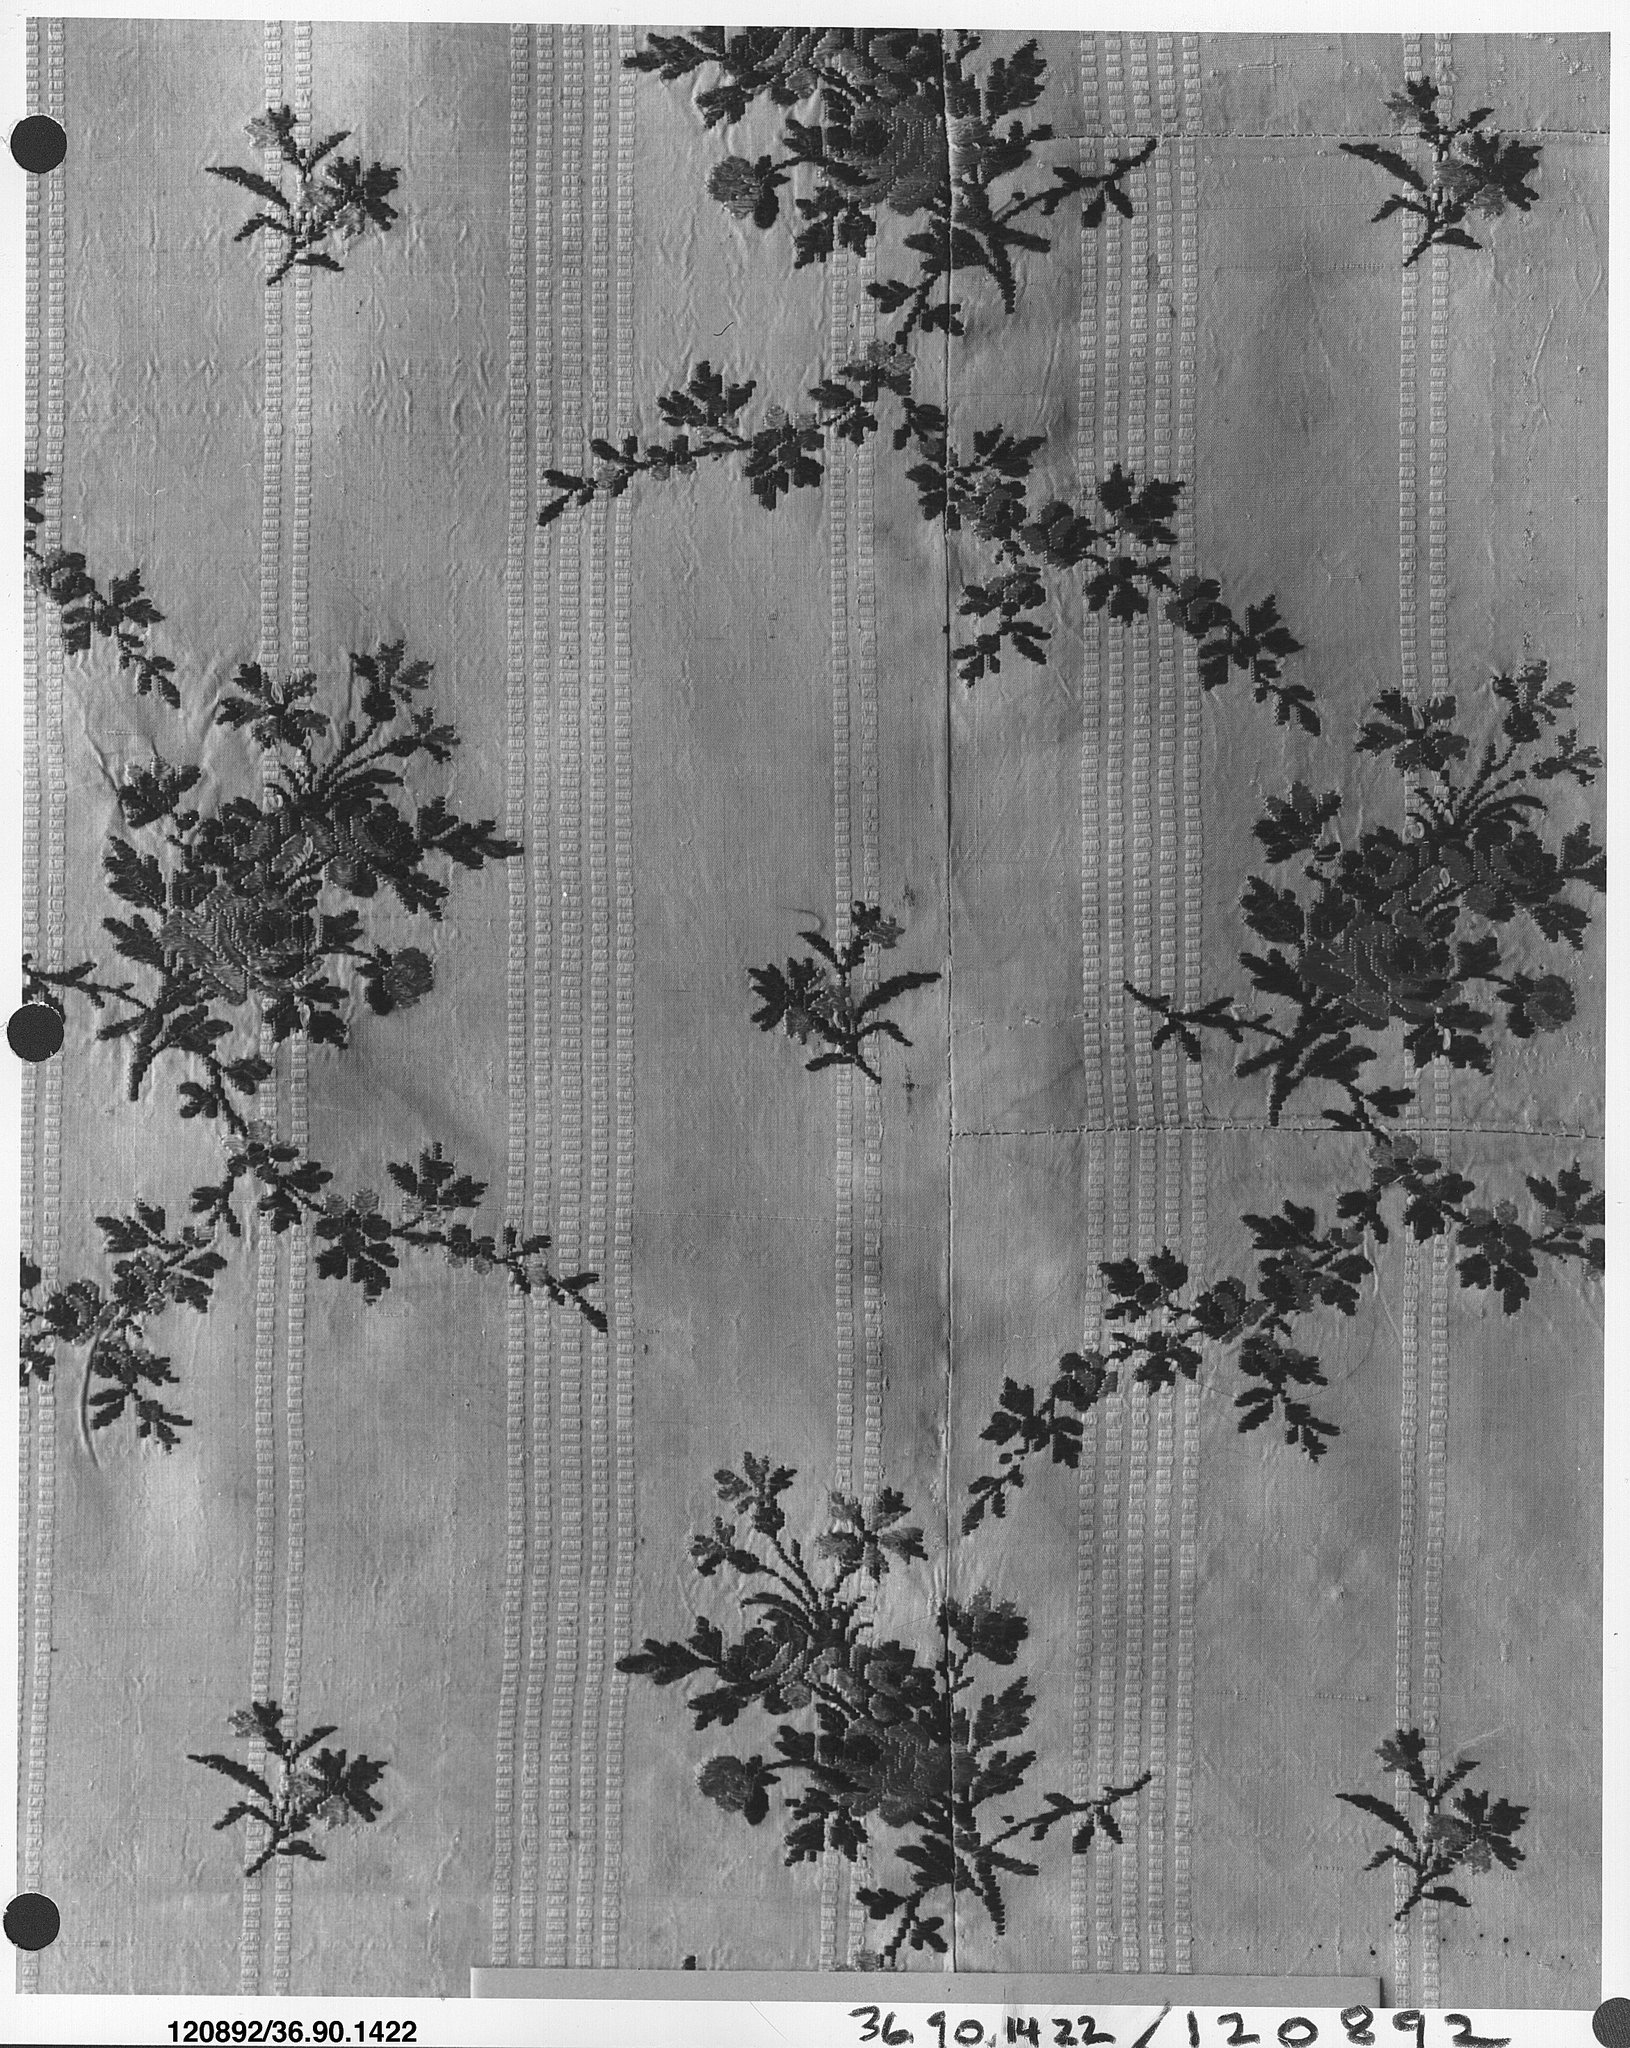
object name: piece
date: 1701-1800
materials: silk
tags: flowers,leaves